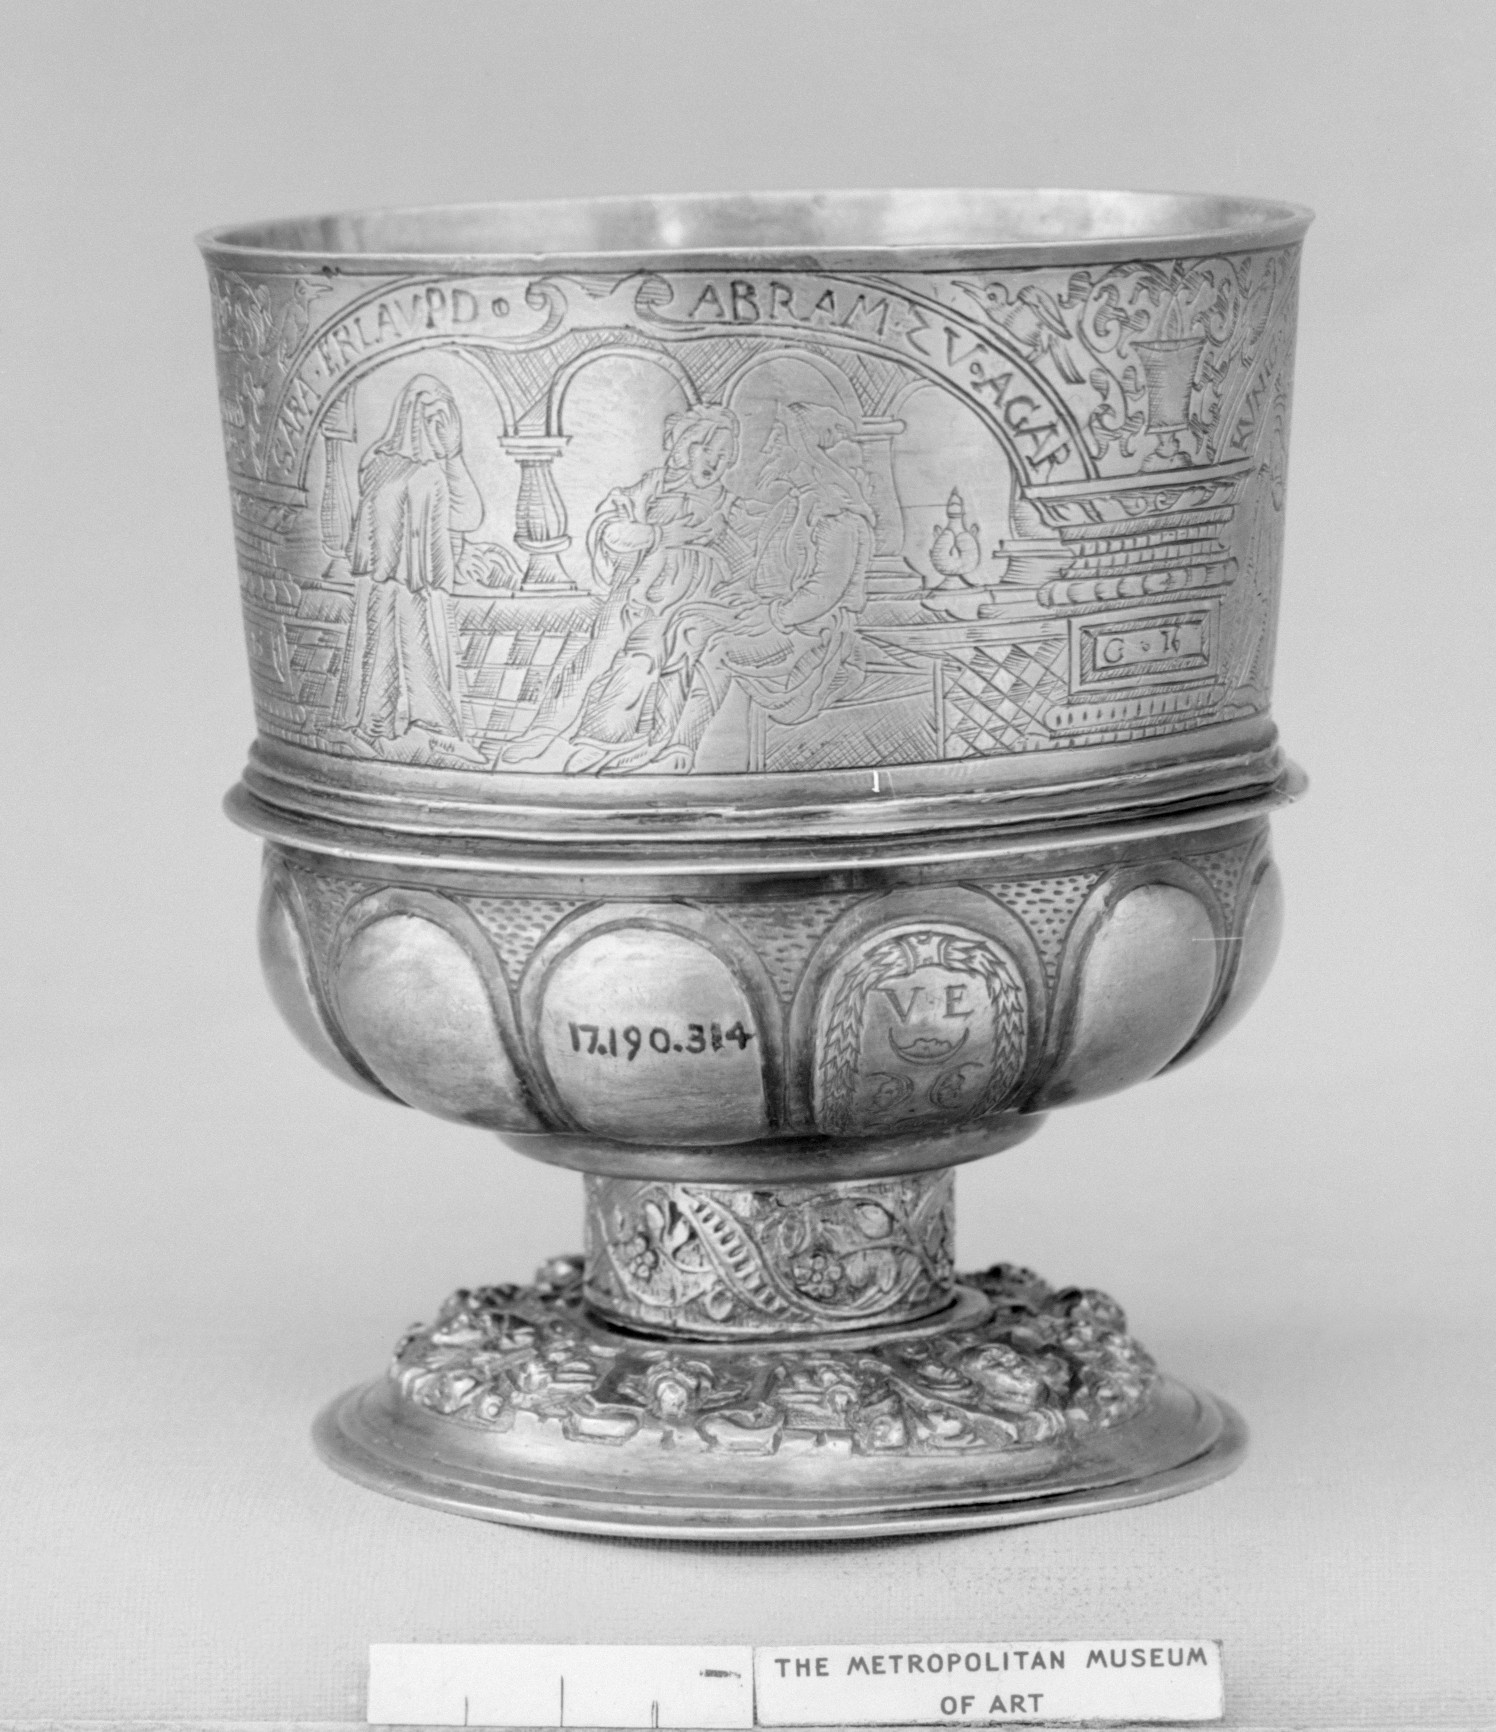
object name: cup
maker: hans heinrich holzhalb i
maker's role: maker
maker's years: 1532-1632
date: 1601-1700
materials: gilt, silver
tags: women